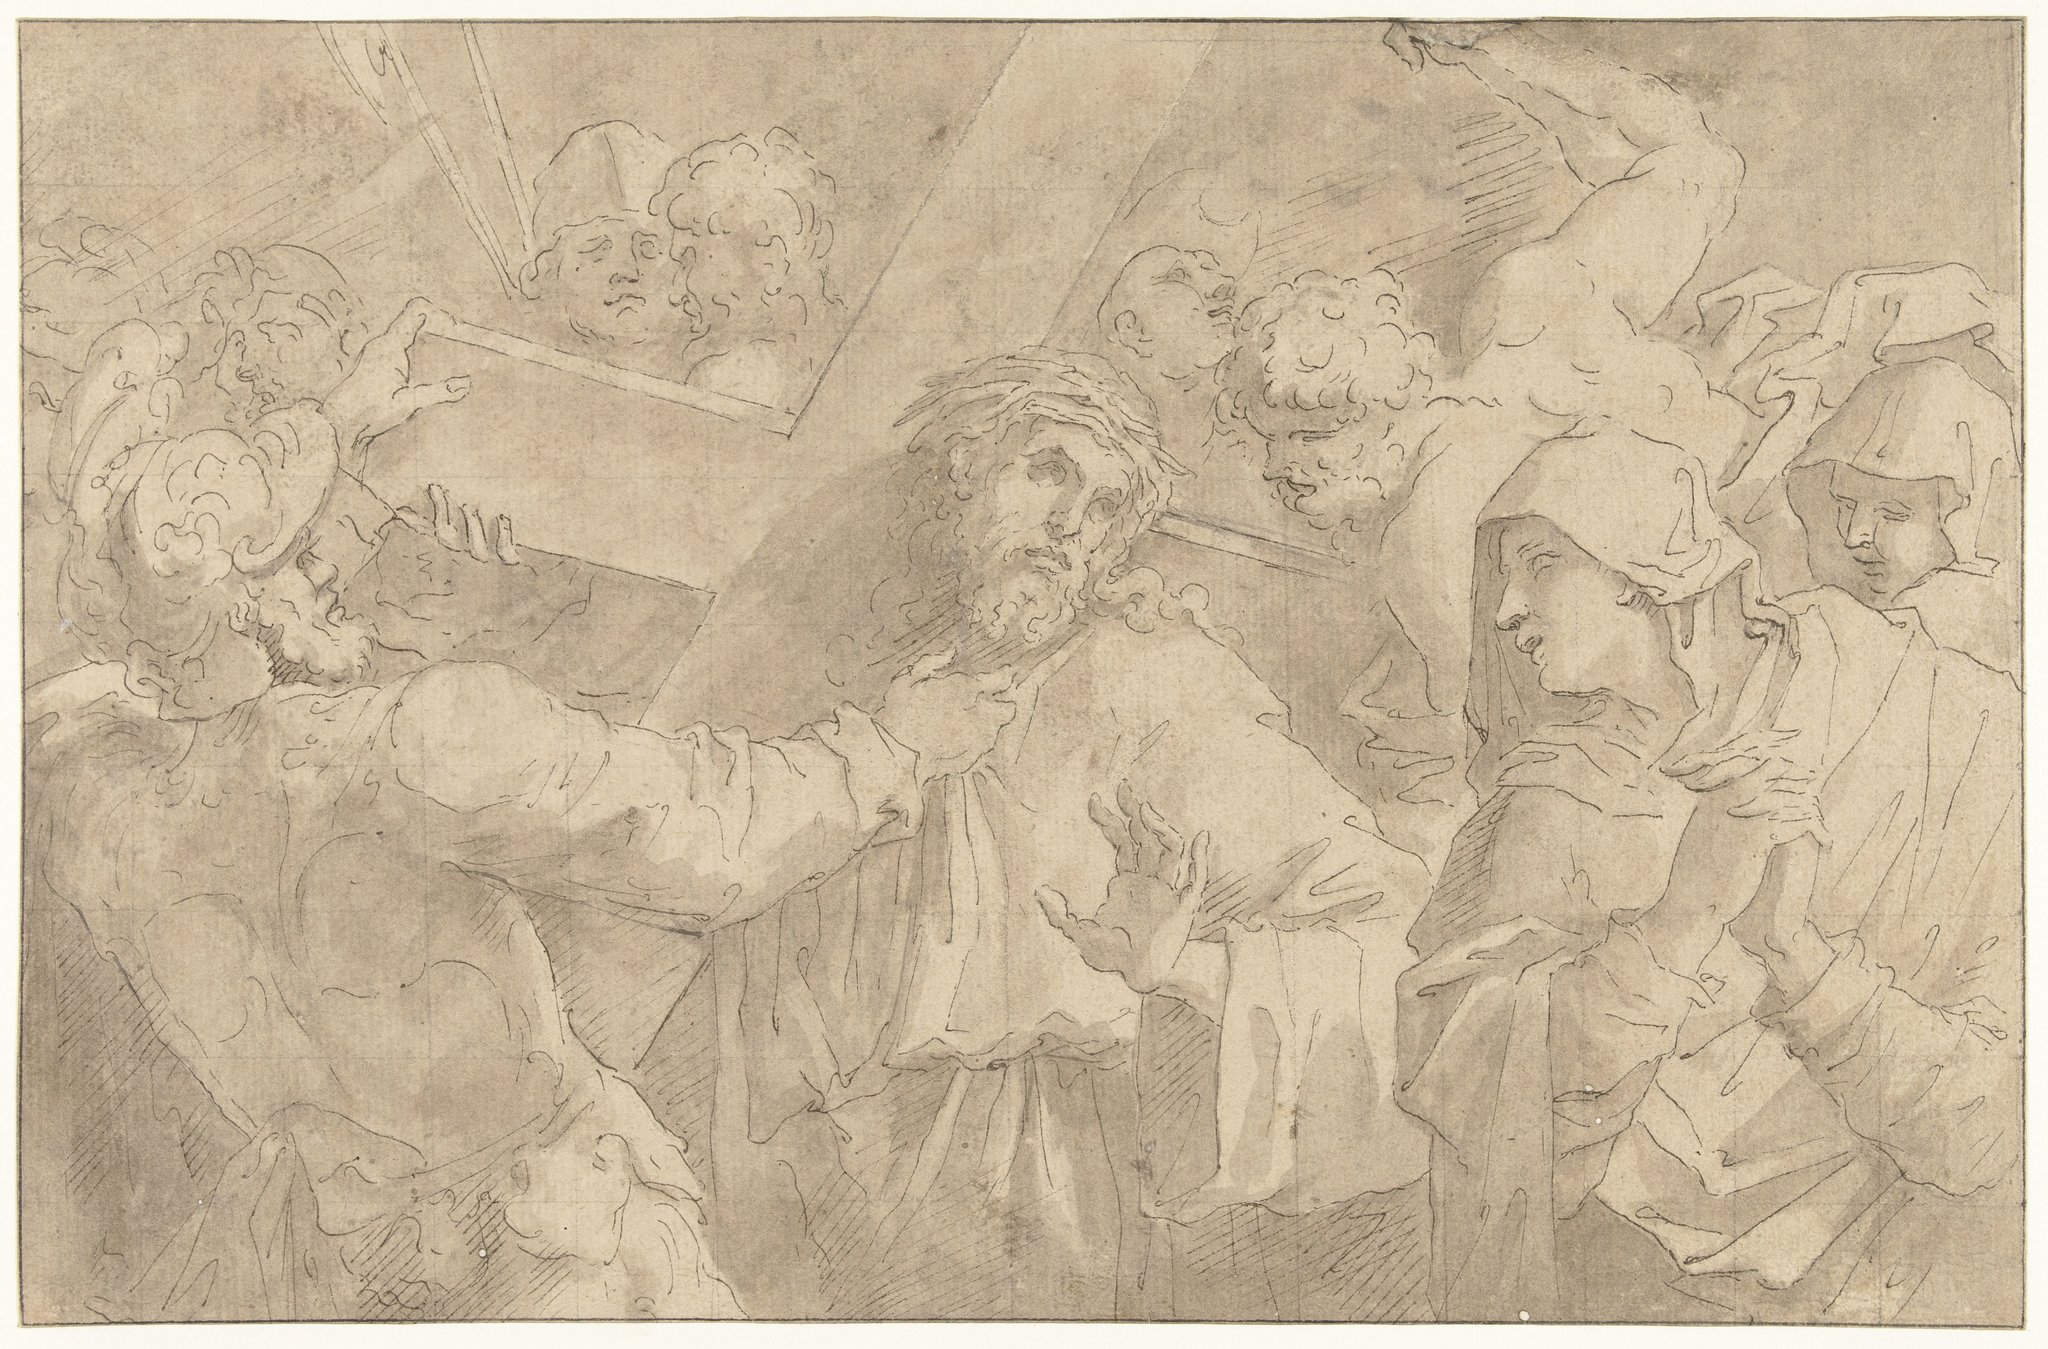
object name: drawing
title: Christus op de kruisweg, sprekend met de vrouwen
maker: giacomo cavedone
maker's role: draughtsman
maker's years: 1577-1660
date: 1587-1660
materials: chalk, ink, paper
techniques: brush, pen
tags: carrying of the cross: christ bearing the cross, alone or with the help of others (e.g. simon the cyrenian)